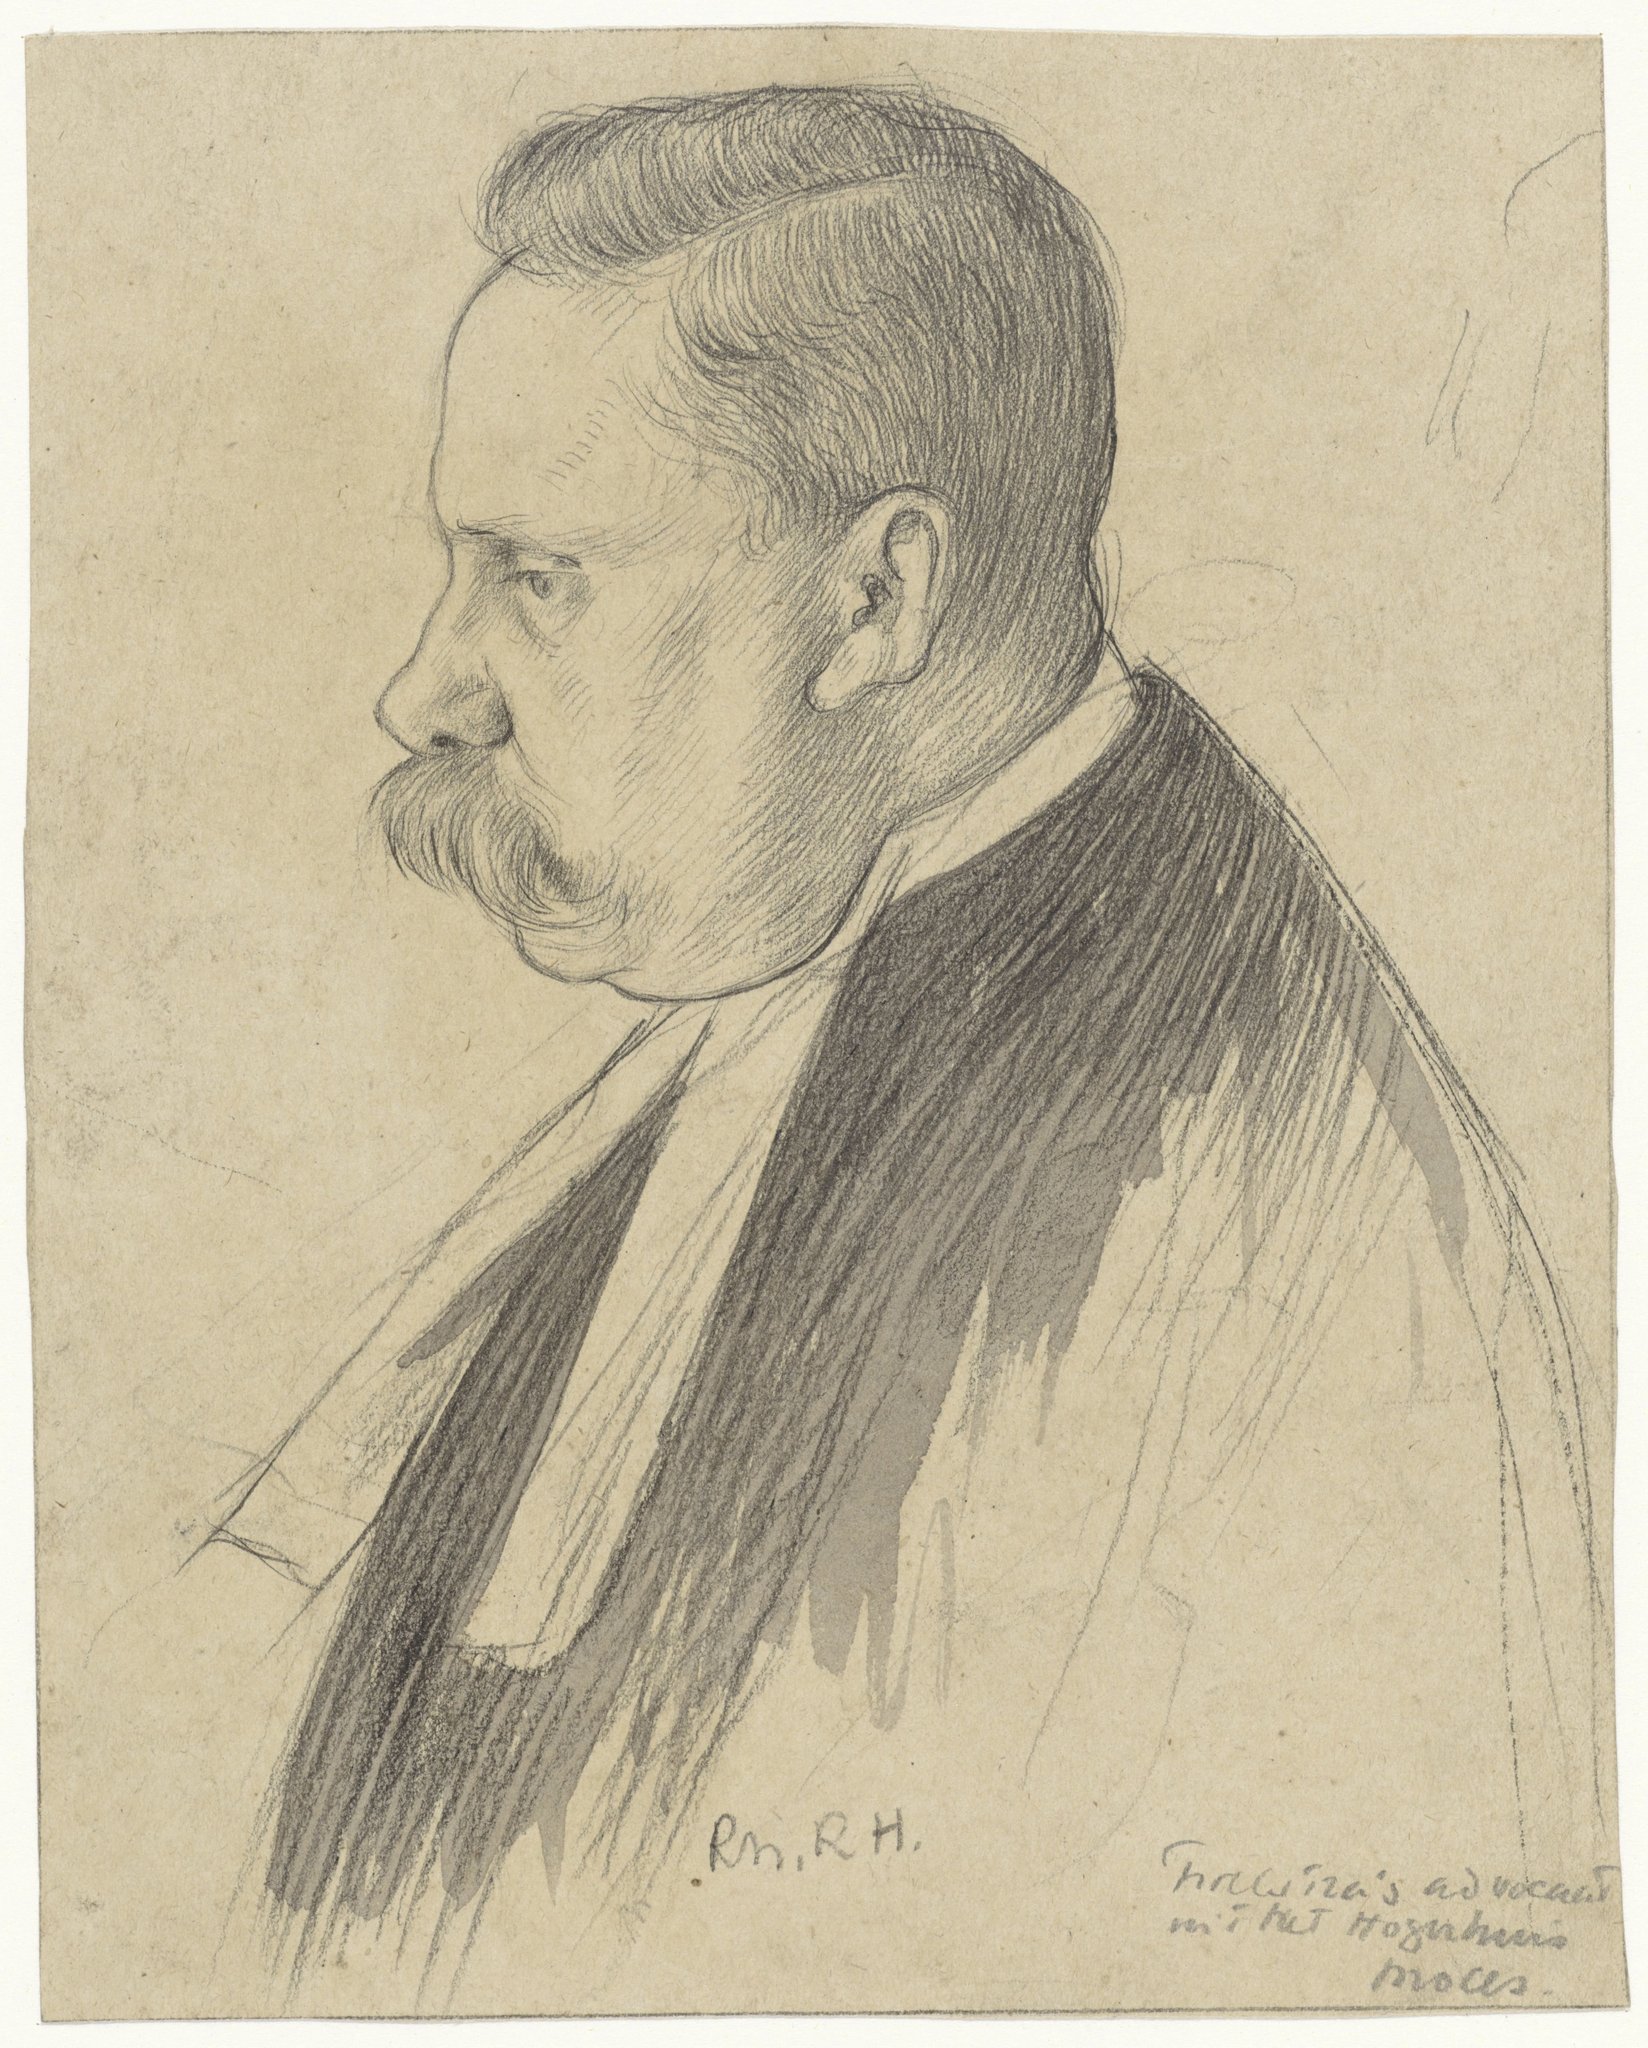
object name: drawing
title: Troelstra's advocaat in het Hogerhuis-proces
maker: richard nicolaüs roland holst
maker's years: 1868-1938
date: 1878-1938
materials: chalk, paper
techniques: brush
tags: anonymous historical person portrayed alone, lawyer, attorney at law